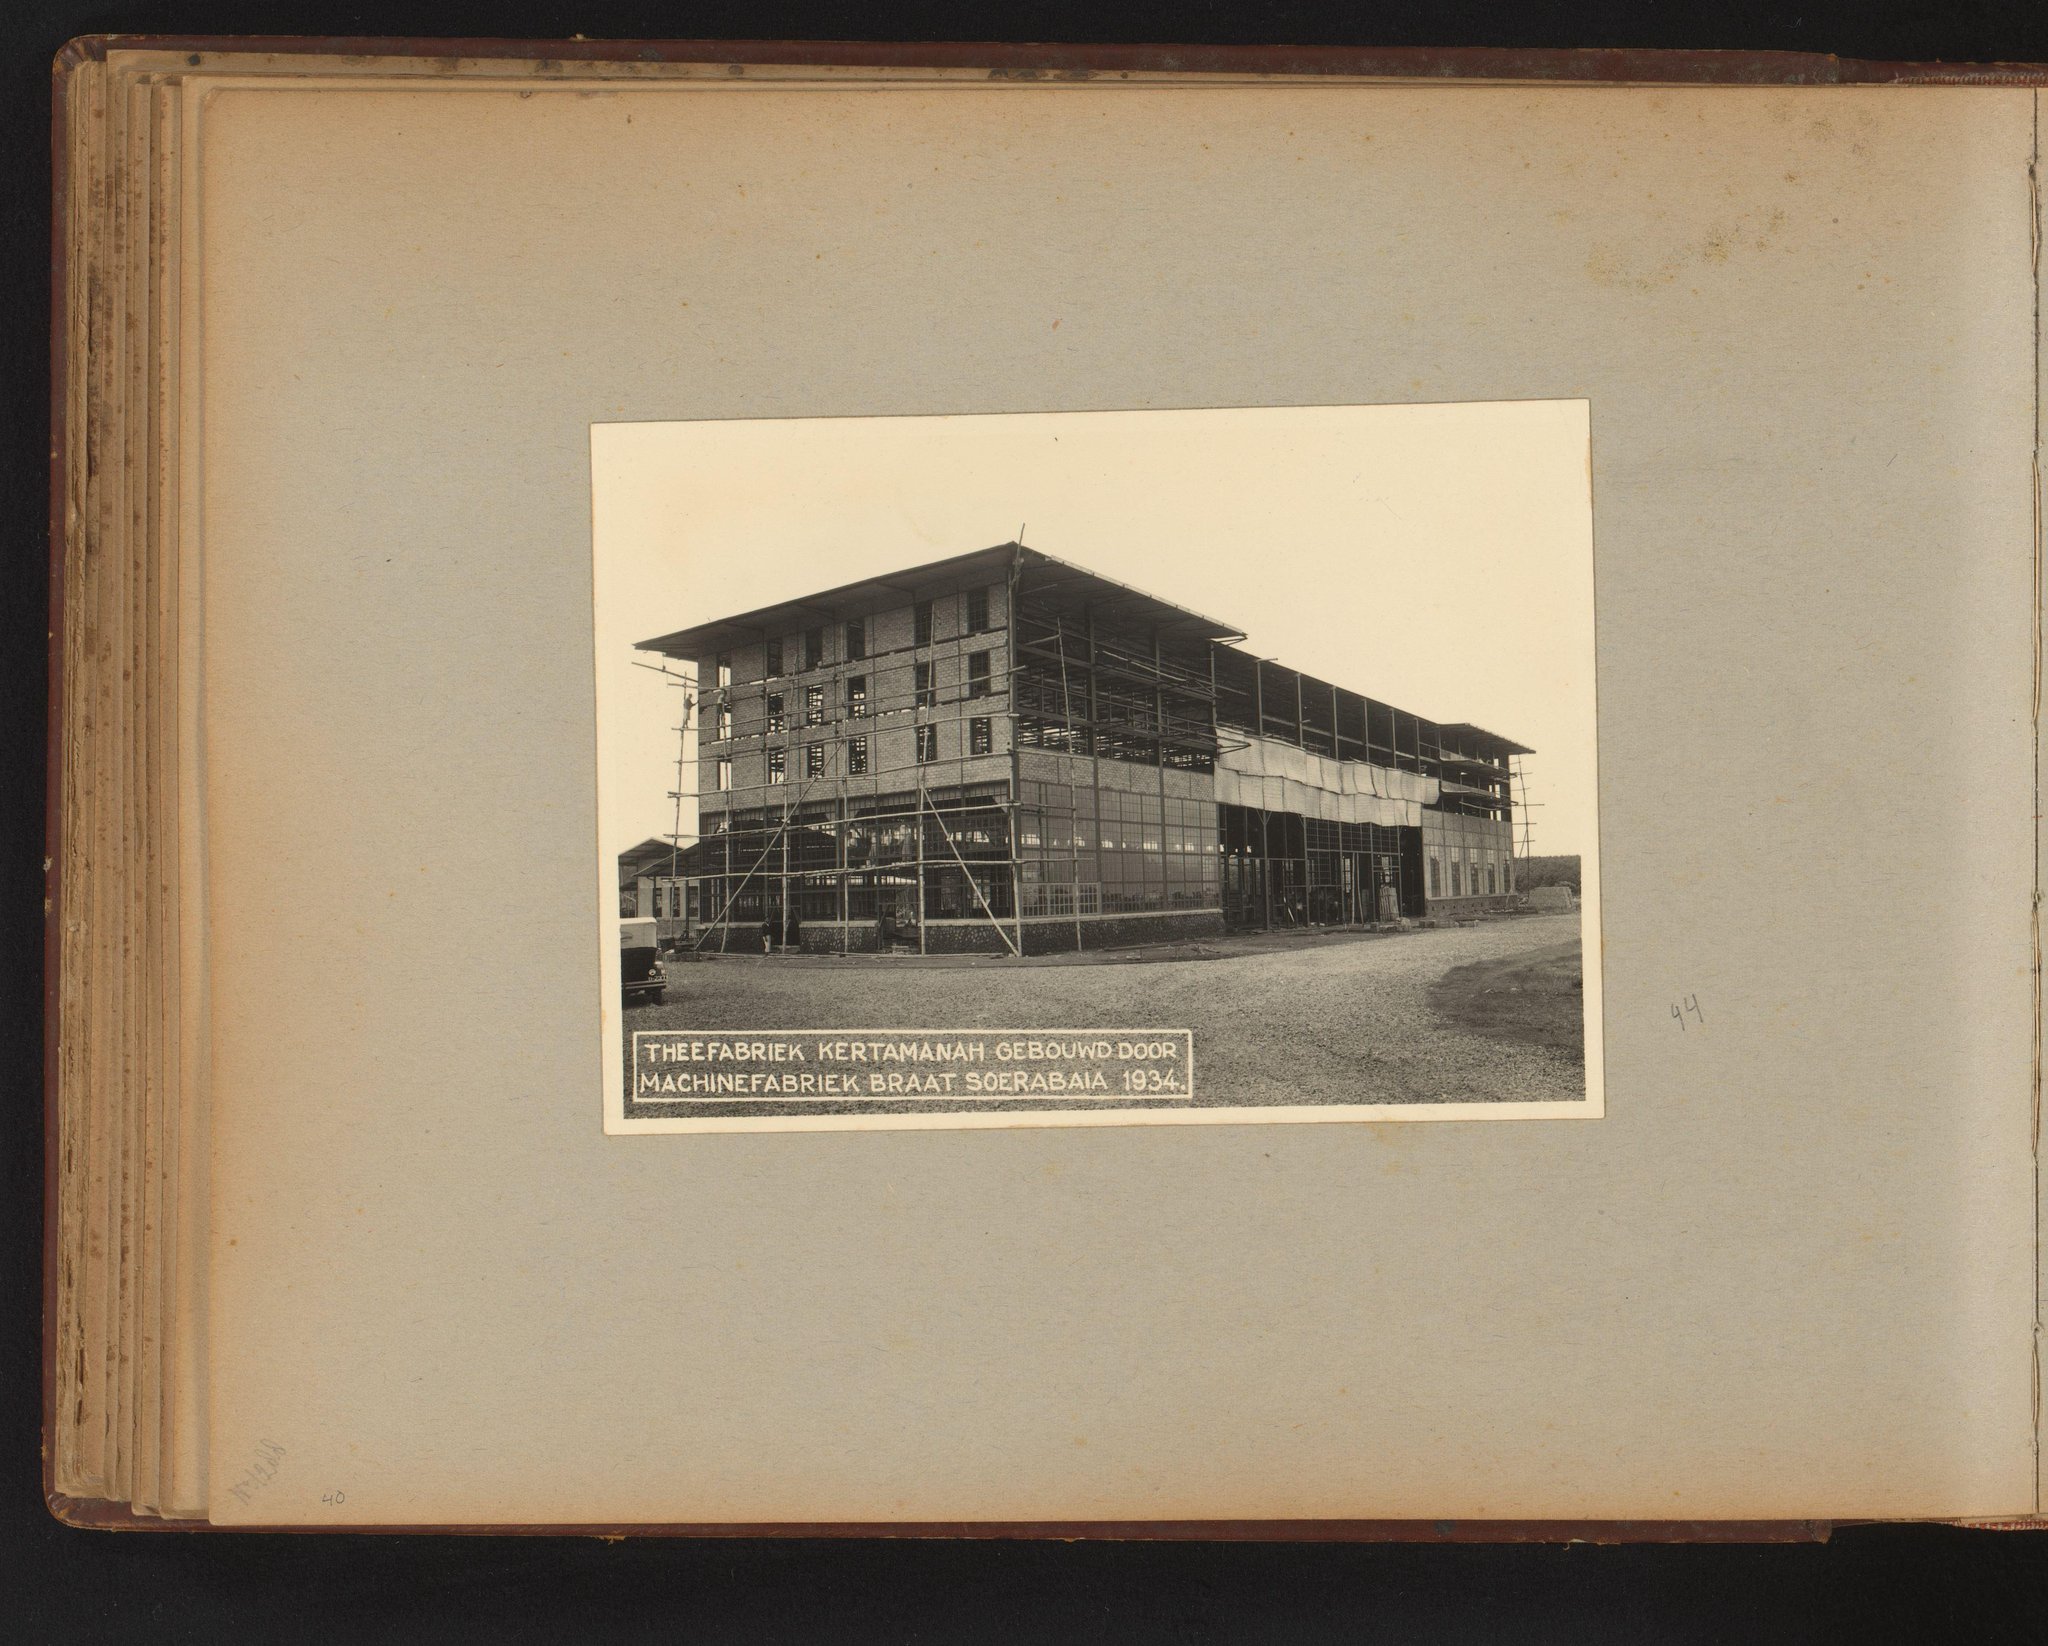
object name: photograph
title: Theefabriek Kertamanah gebouwd door Machinefabriek Braat Soerabaia 1934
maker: d.h. buys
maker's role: fotograaf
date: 1934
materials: cardboard, photographic support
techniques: gelatin silver print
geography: bandung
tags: factory-building, making the overground structures (~ building activities), java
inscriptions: date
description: Albumblad met een foto van de theefabriek Kertamanah ten zuiden van Bandoeng, in aanbouw in 1934. Onderdeel van een fotoalbum met foto's van machines en constructies van de N.V. Machinefabriek Braat te Soerabaja, Soekaboemi en Tegal uit de periode 1931-1937.